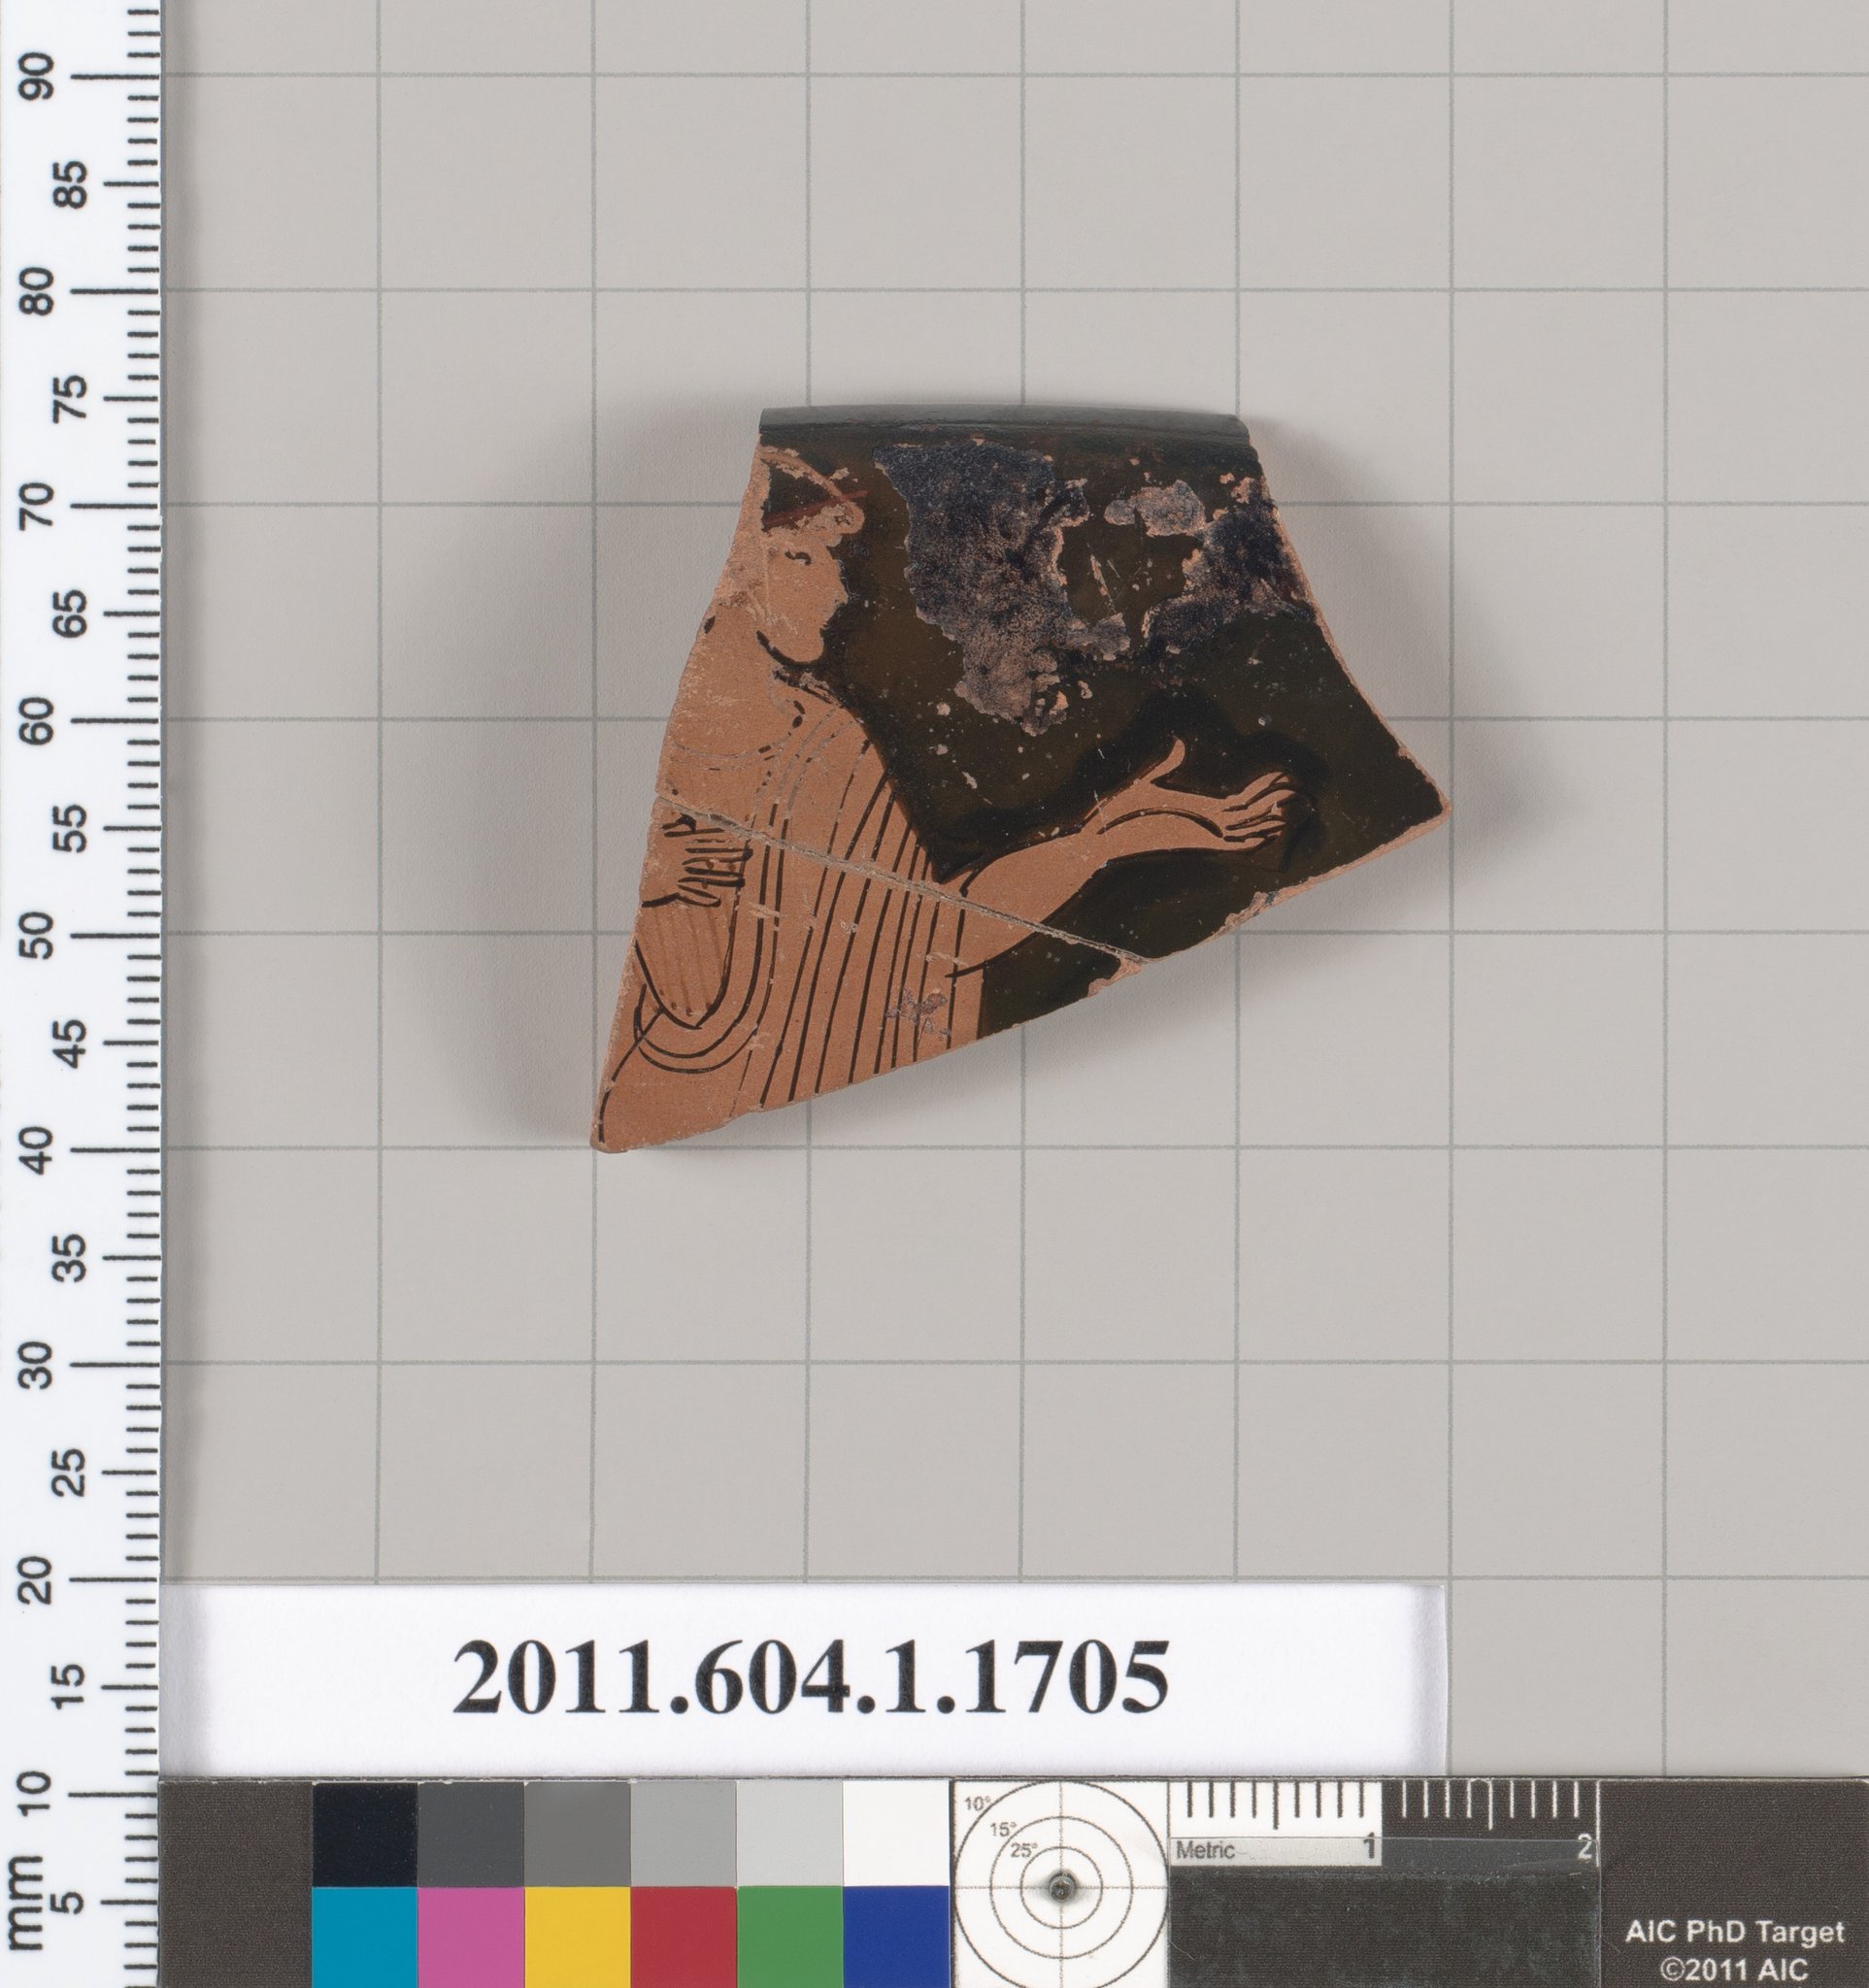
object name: kylix fragment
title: Terracotta rim fragment of a kylix (drinking cup)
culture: greek, attic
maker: painter of munich 2676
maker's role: artist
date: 470-460 BCE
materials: terracotta